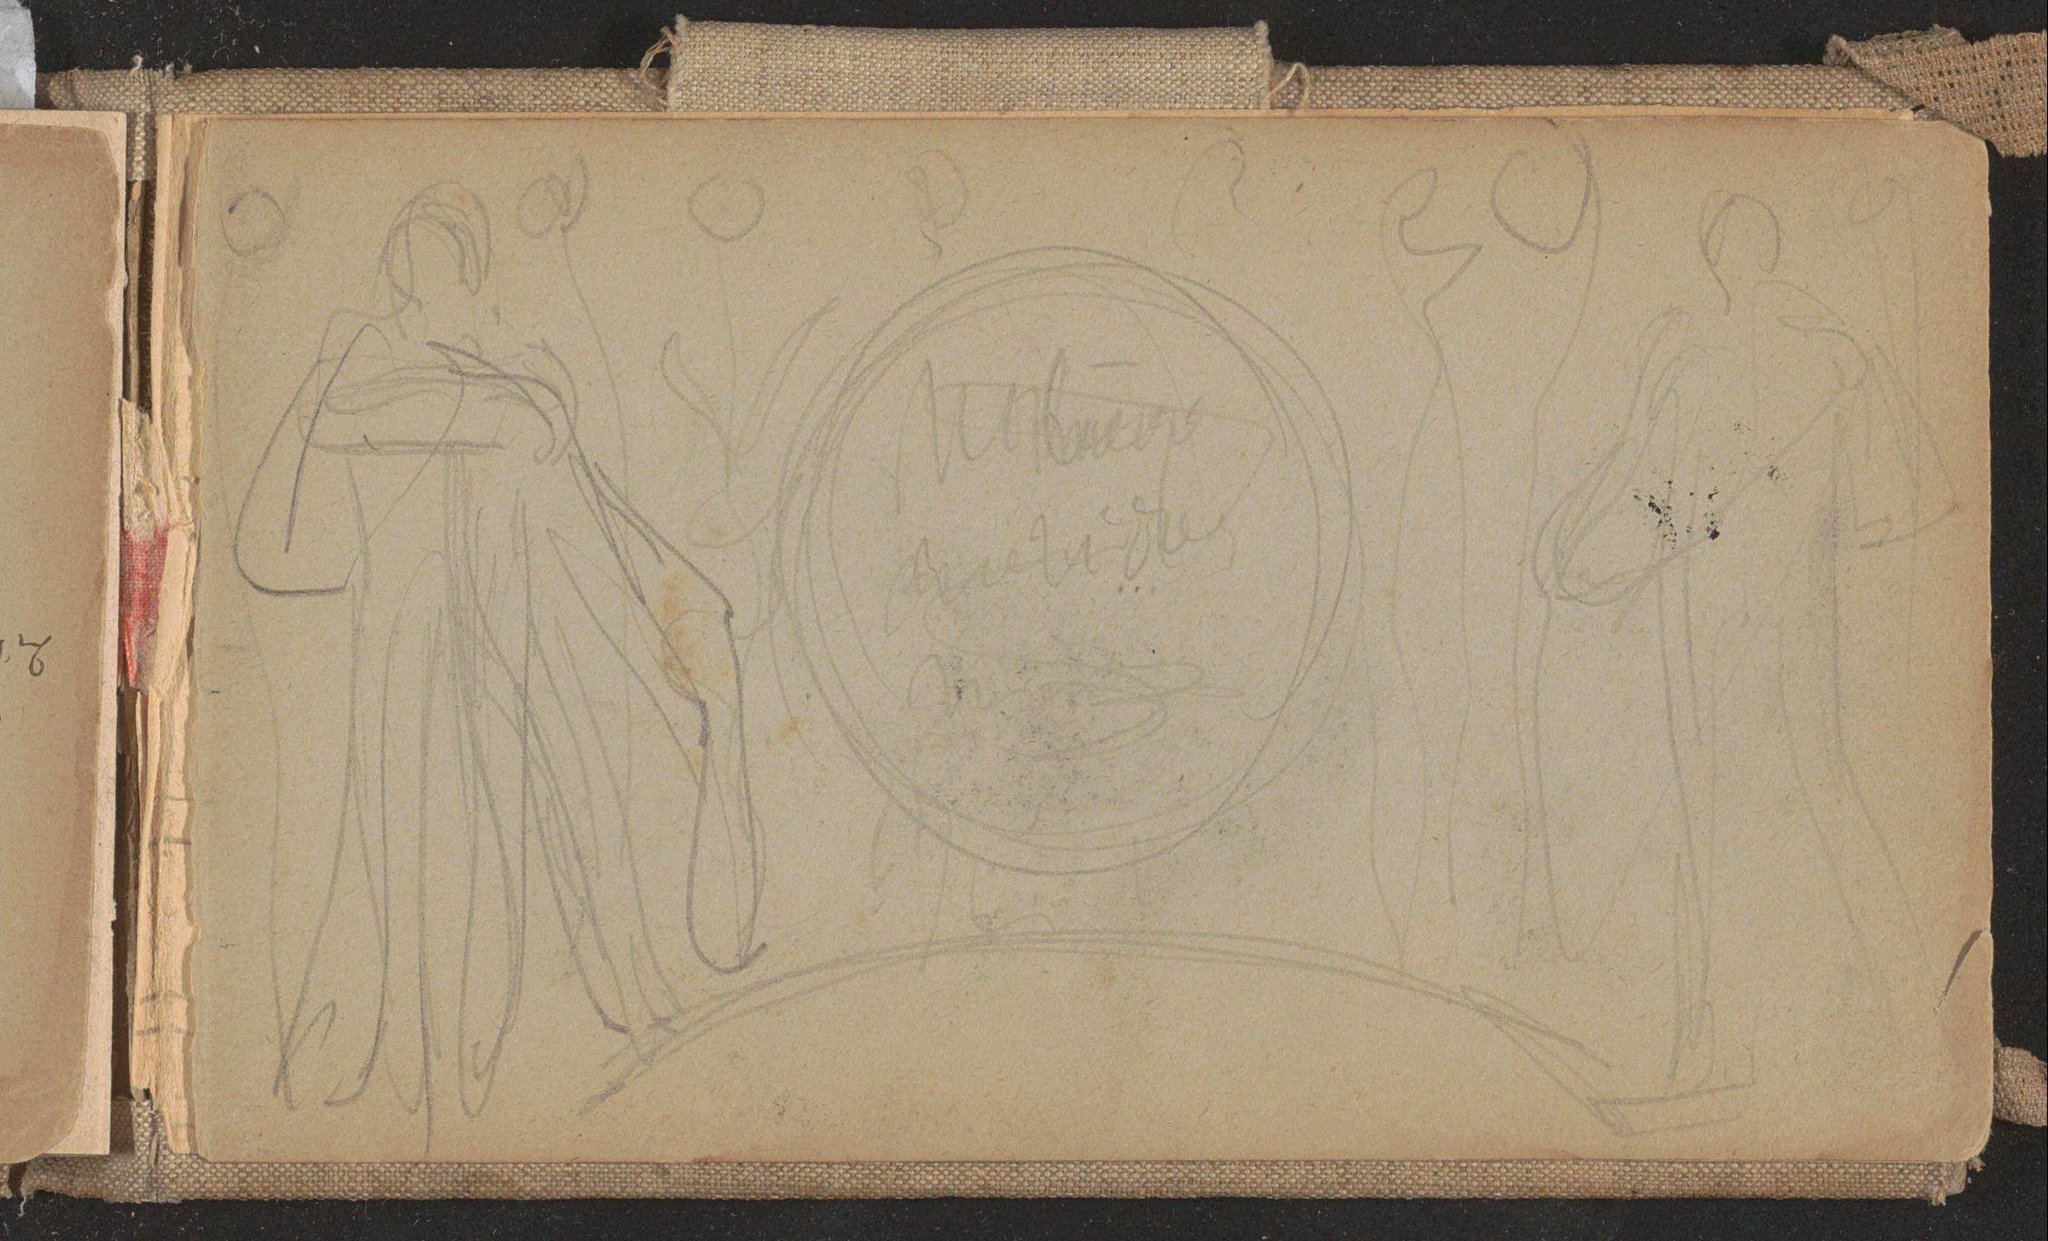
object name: sketchbook leaf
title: Groep staande figuren en bloemen in een halve cirkel rond een cirkel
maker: antoon derkinderen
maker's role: draughtsman, painter, print maker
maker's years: 1859-1925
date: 1892-1901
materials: paper, pencil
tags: standing figure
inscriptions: annotation: ‘[...]’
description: Blad 50 recto uit een schetsboek met 51 bladen.